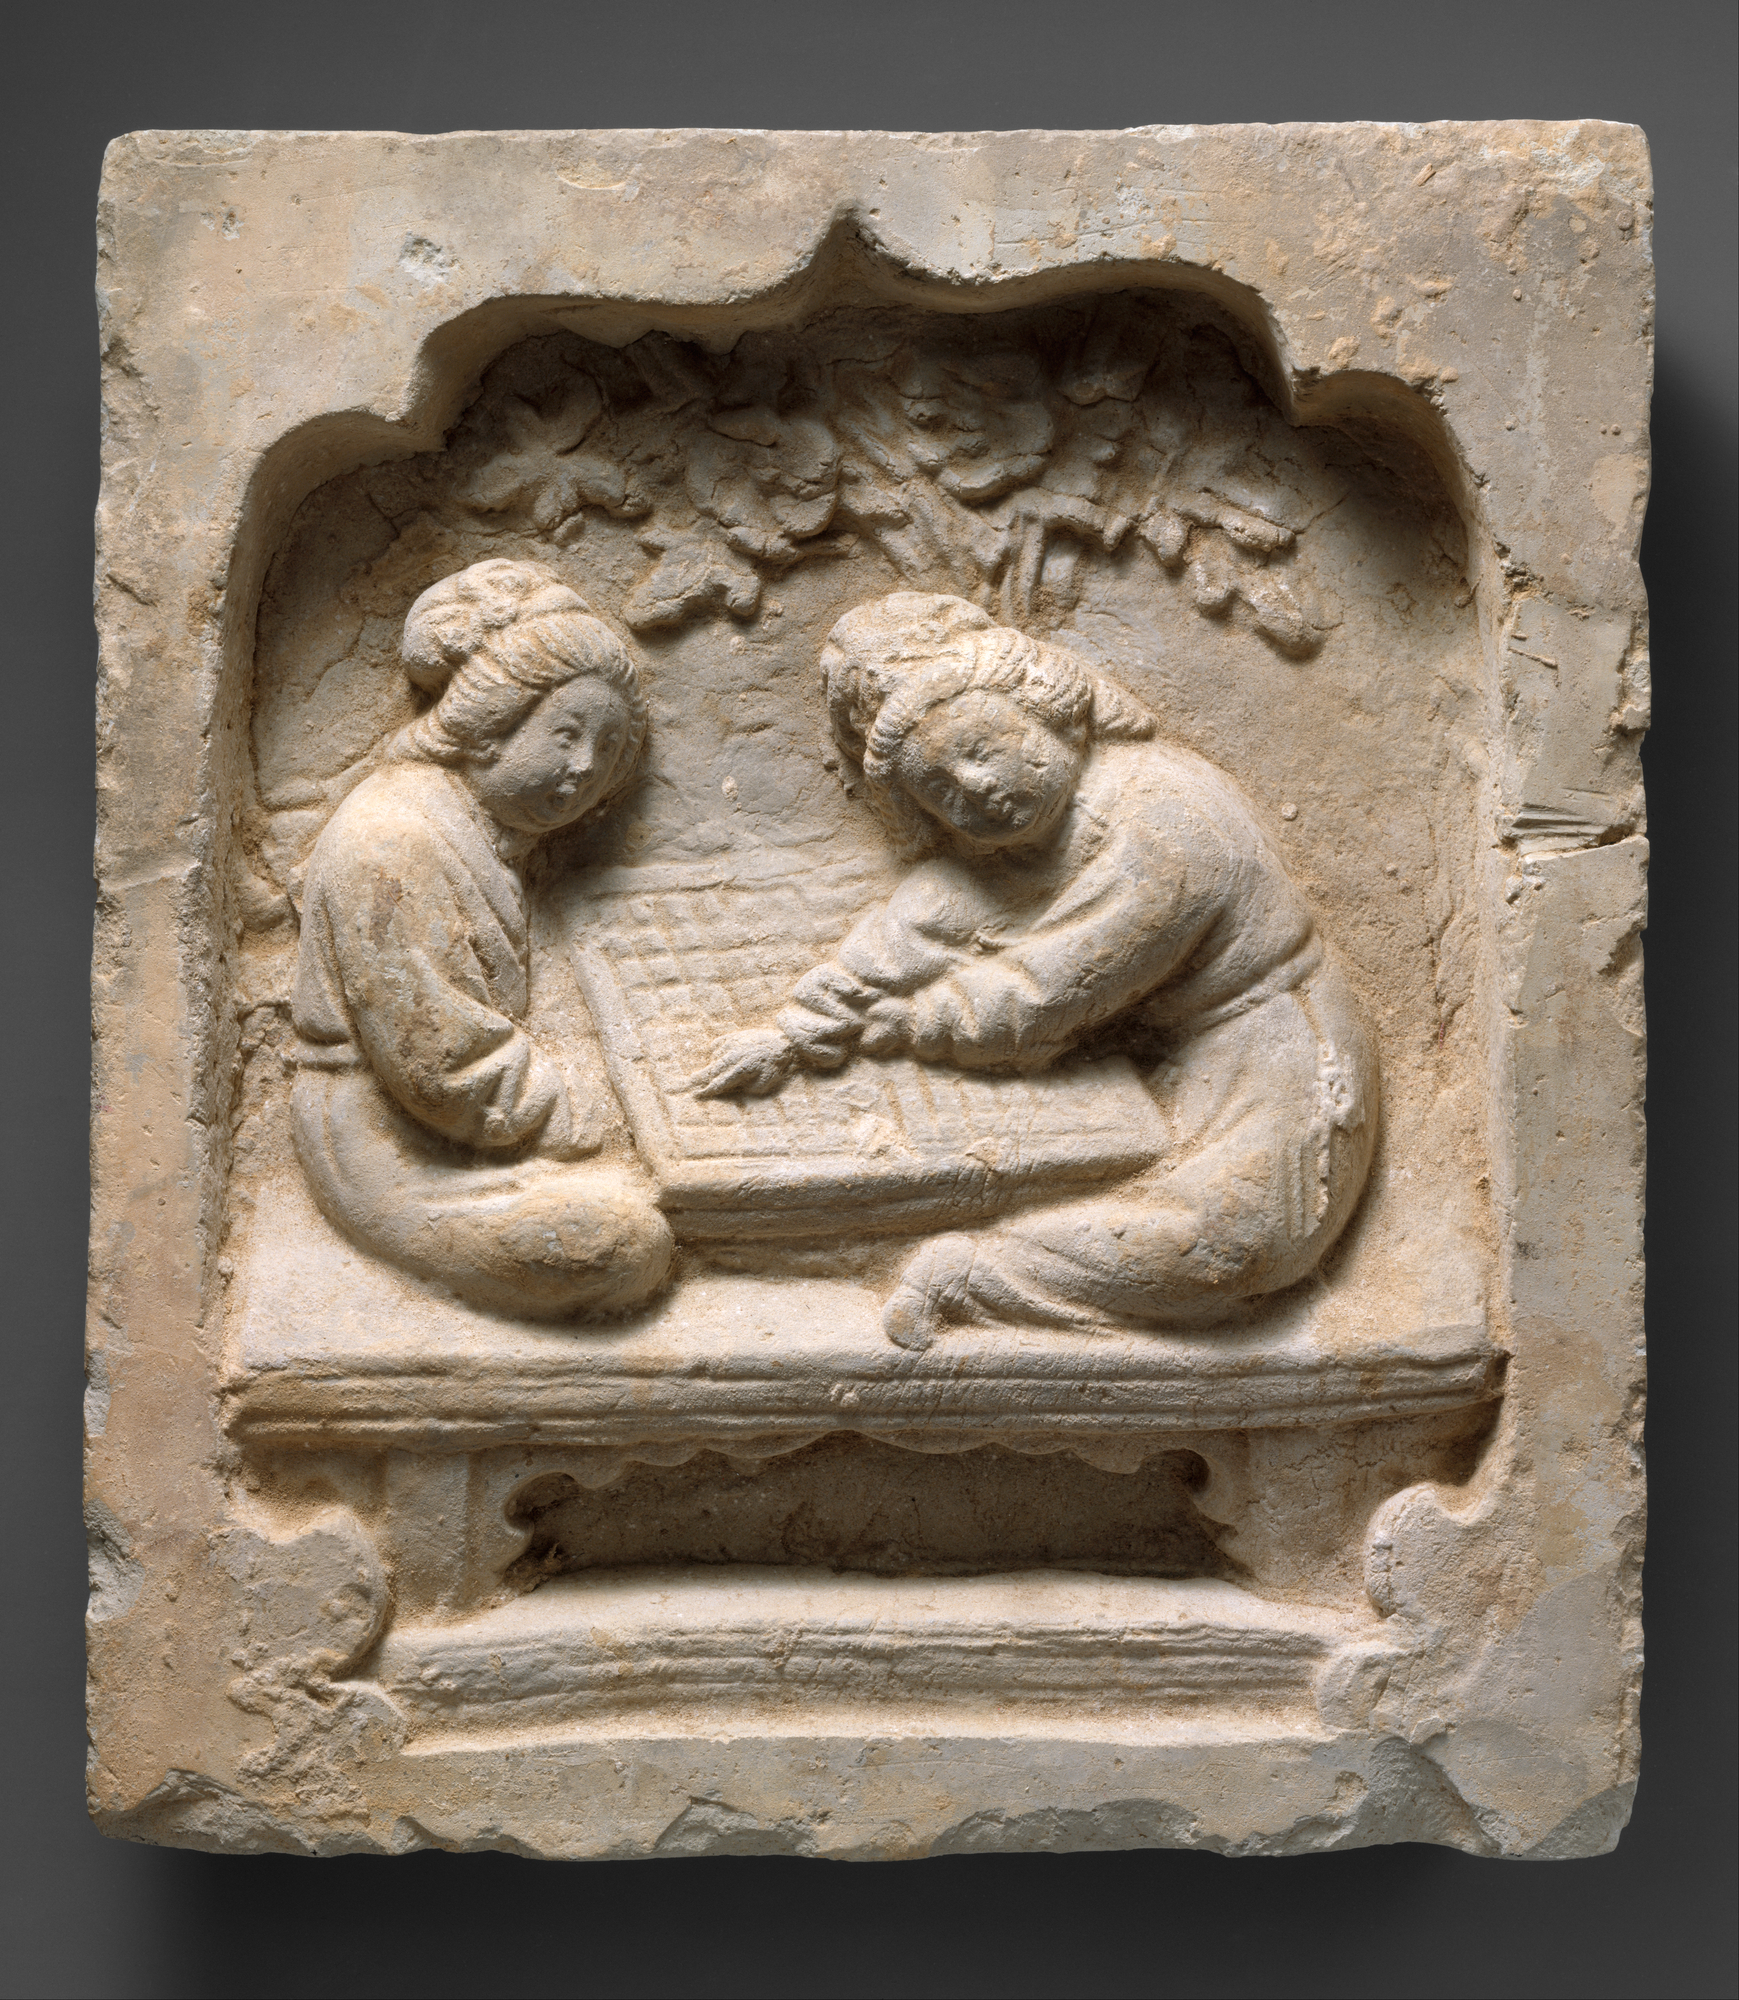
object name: tile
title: Tile with Women Playing a Board Game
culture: chinese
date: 1201-1300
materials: earthenware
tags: women,games